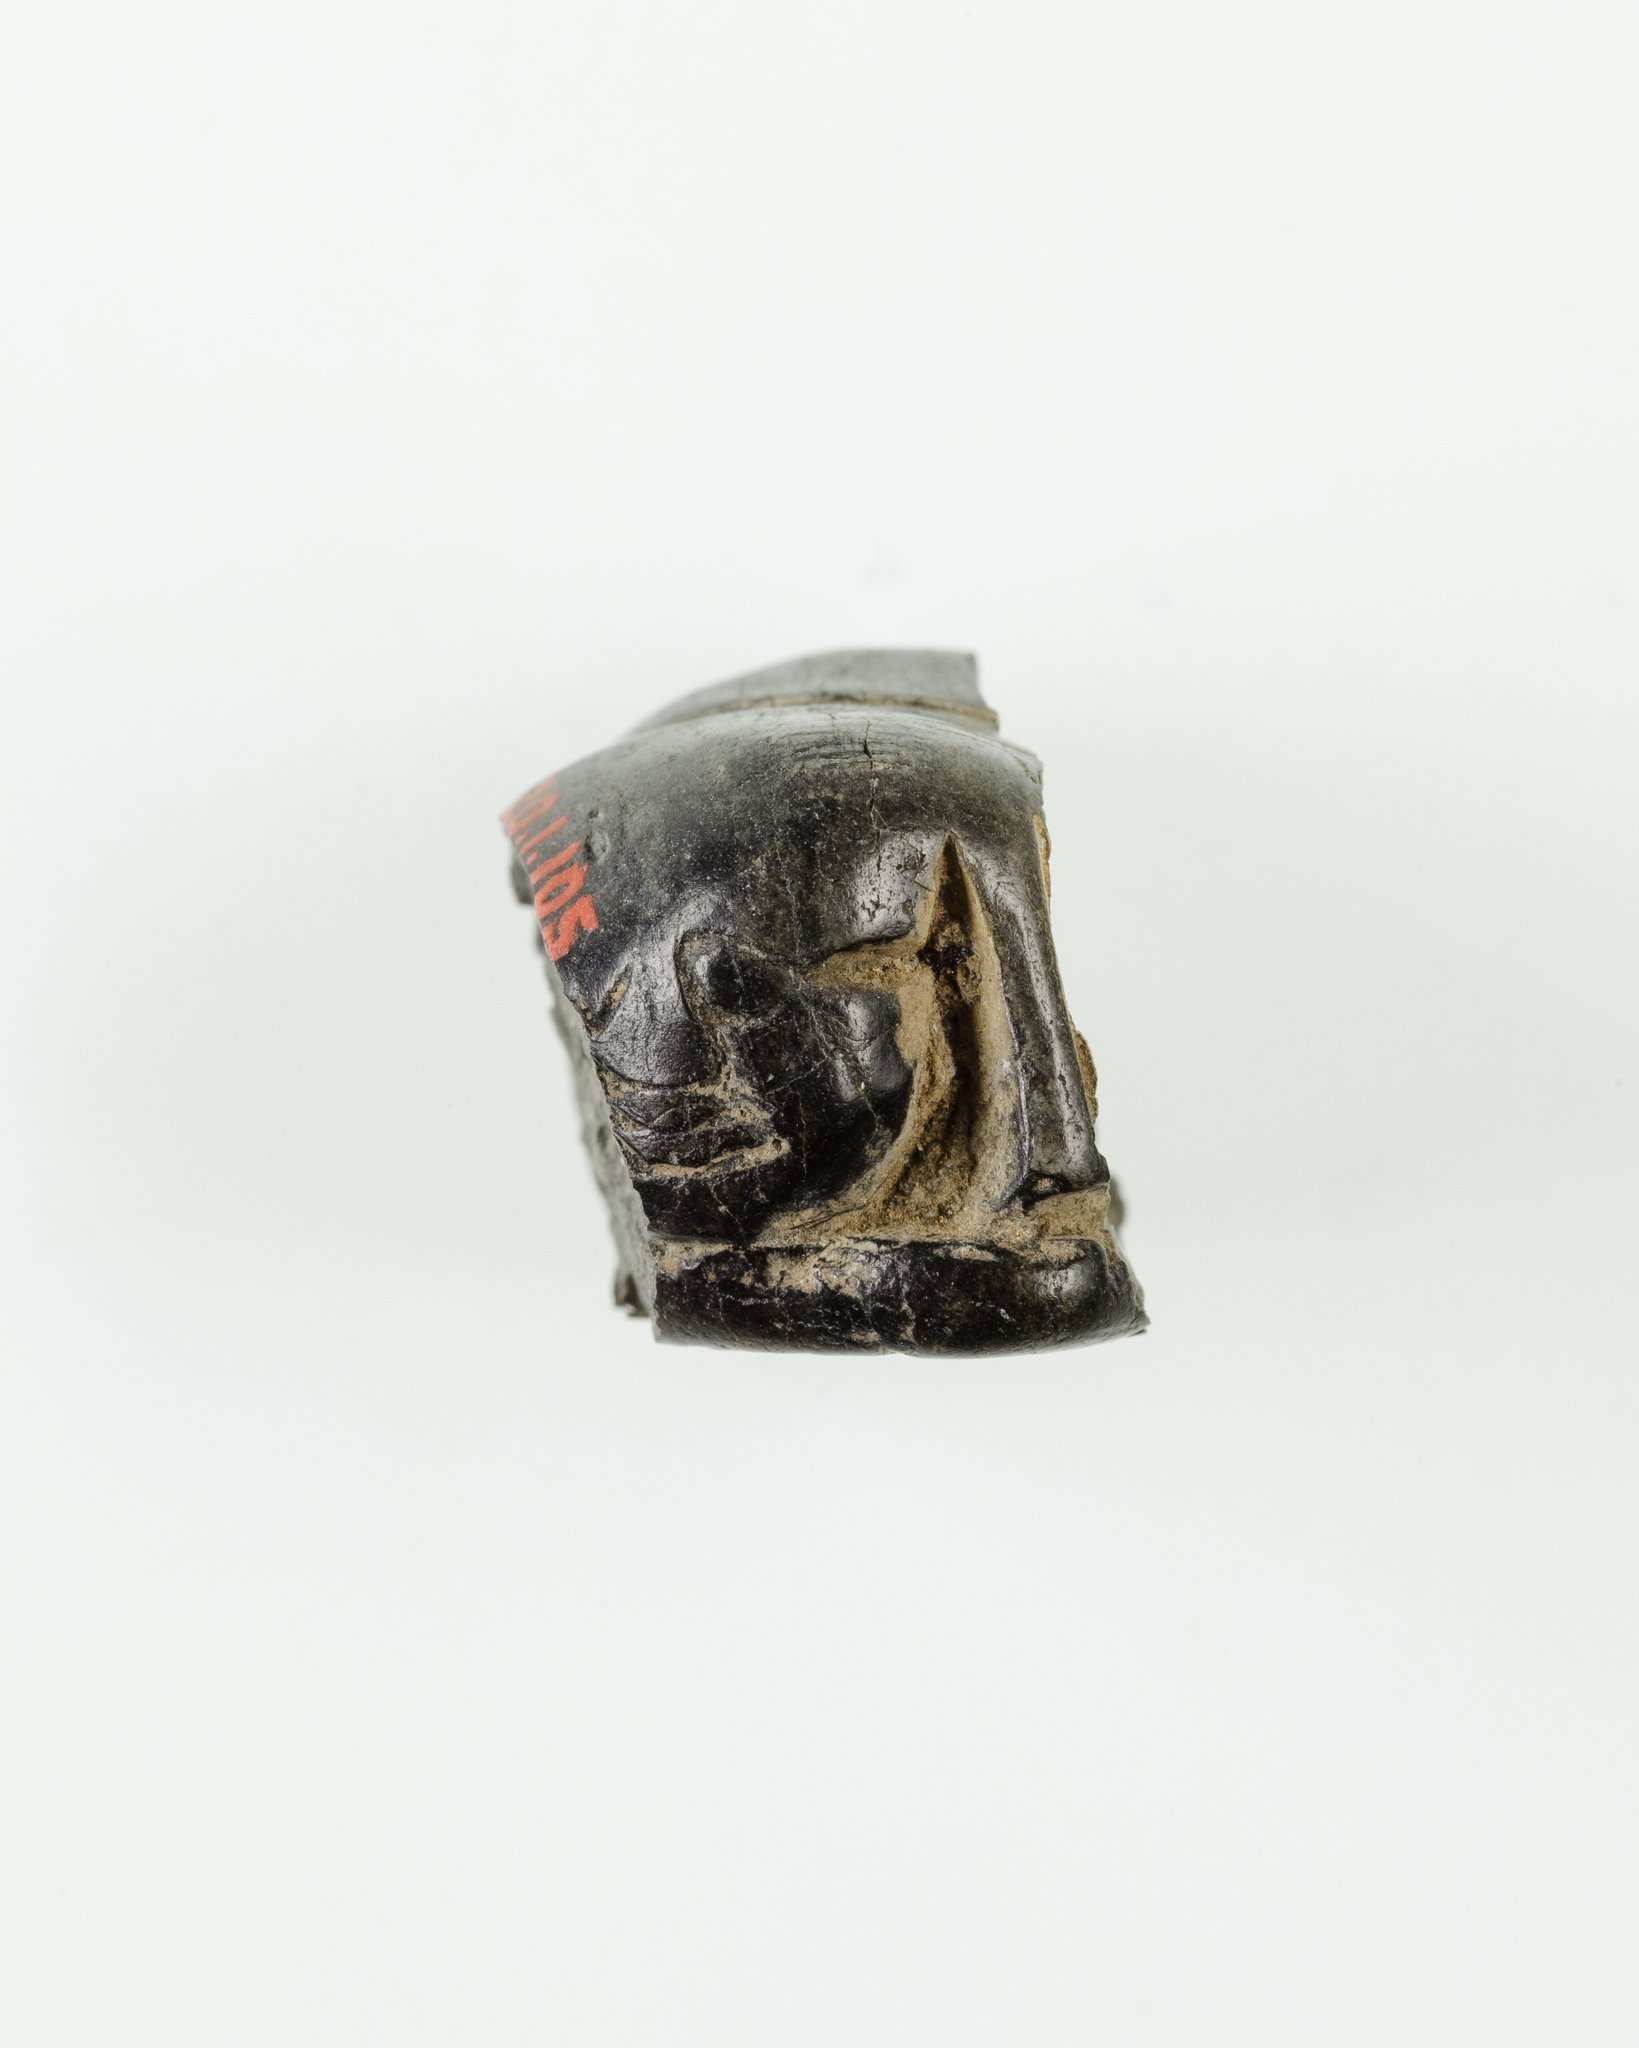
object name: seal amulet, head, linear, geometric, cross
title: Seal-Amulet in the Shape of Heads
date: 2100-2030 BCE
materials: stone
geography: egypt